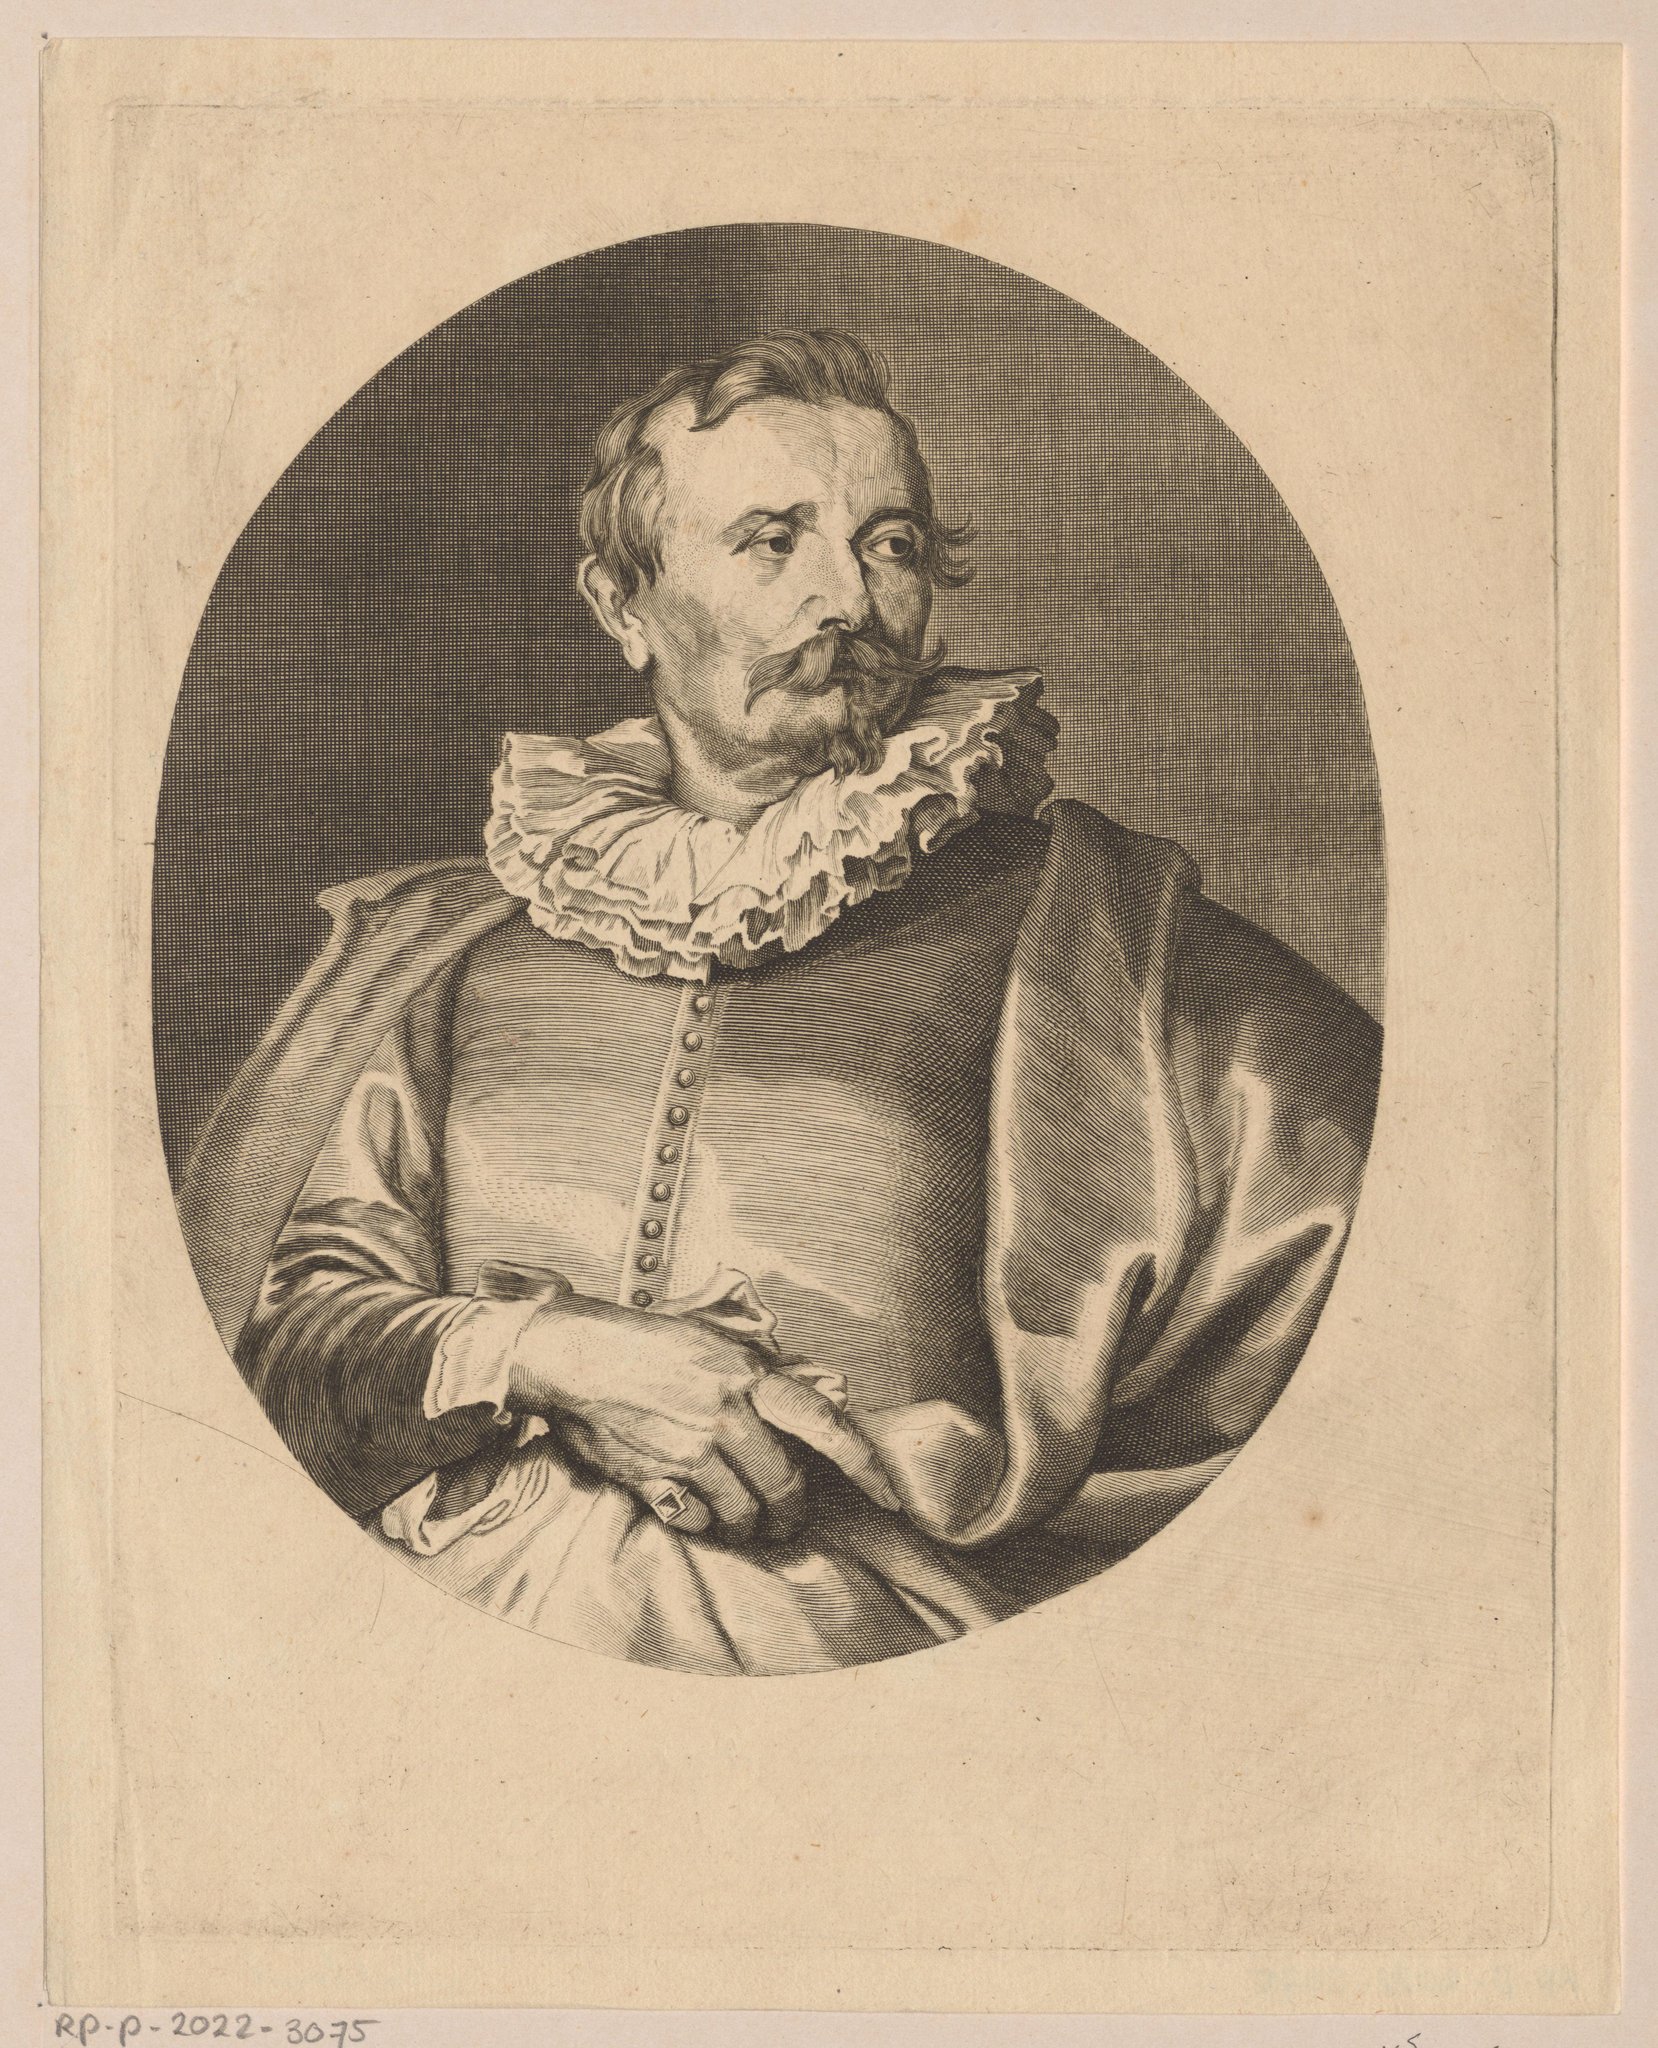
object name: print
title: Portret van Adriaen van Stalbemt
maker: Anonymous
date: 1609-1699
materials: paper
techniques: engraving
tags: antwerp, painter, adriaen van stalbemt, historical persons, portrait, self-portrait of artist